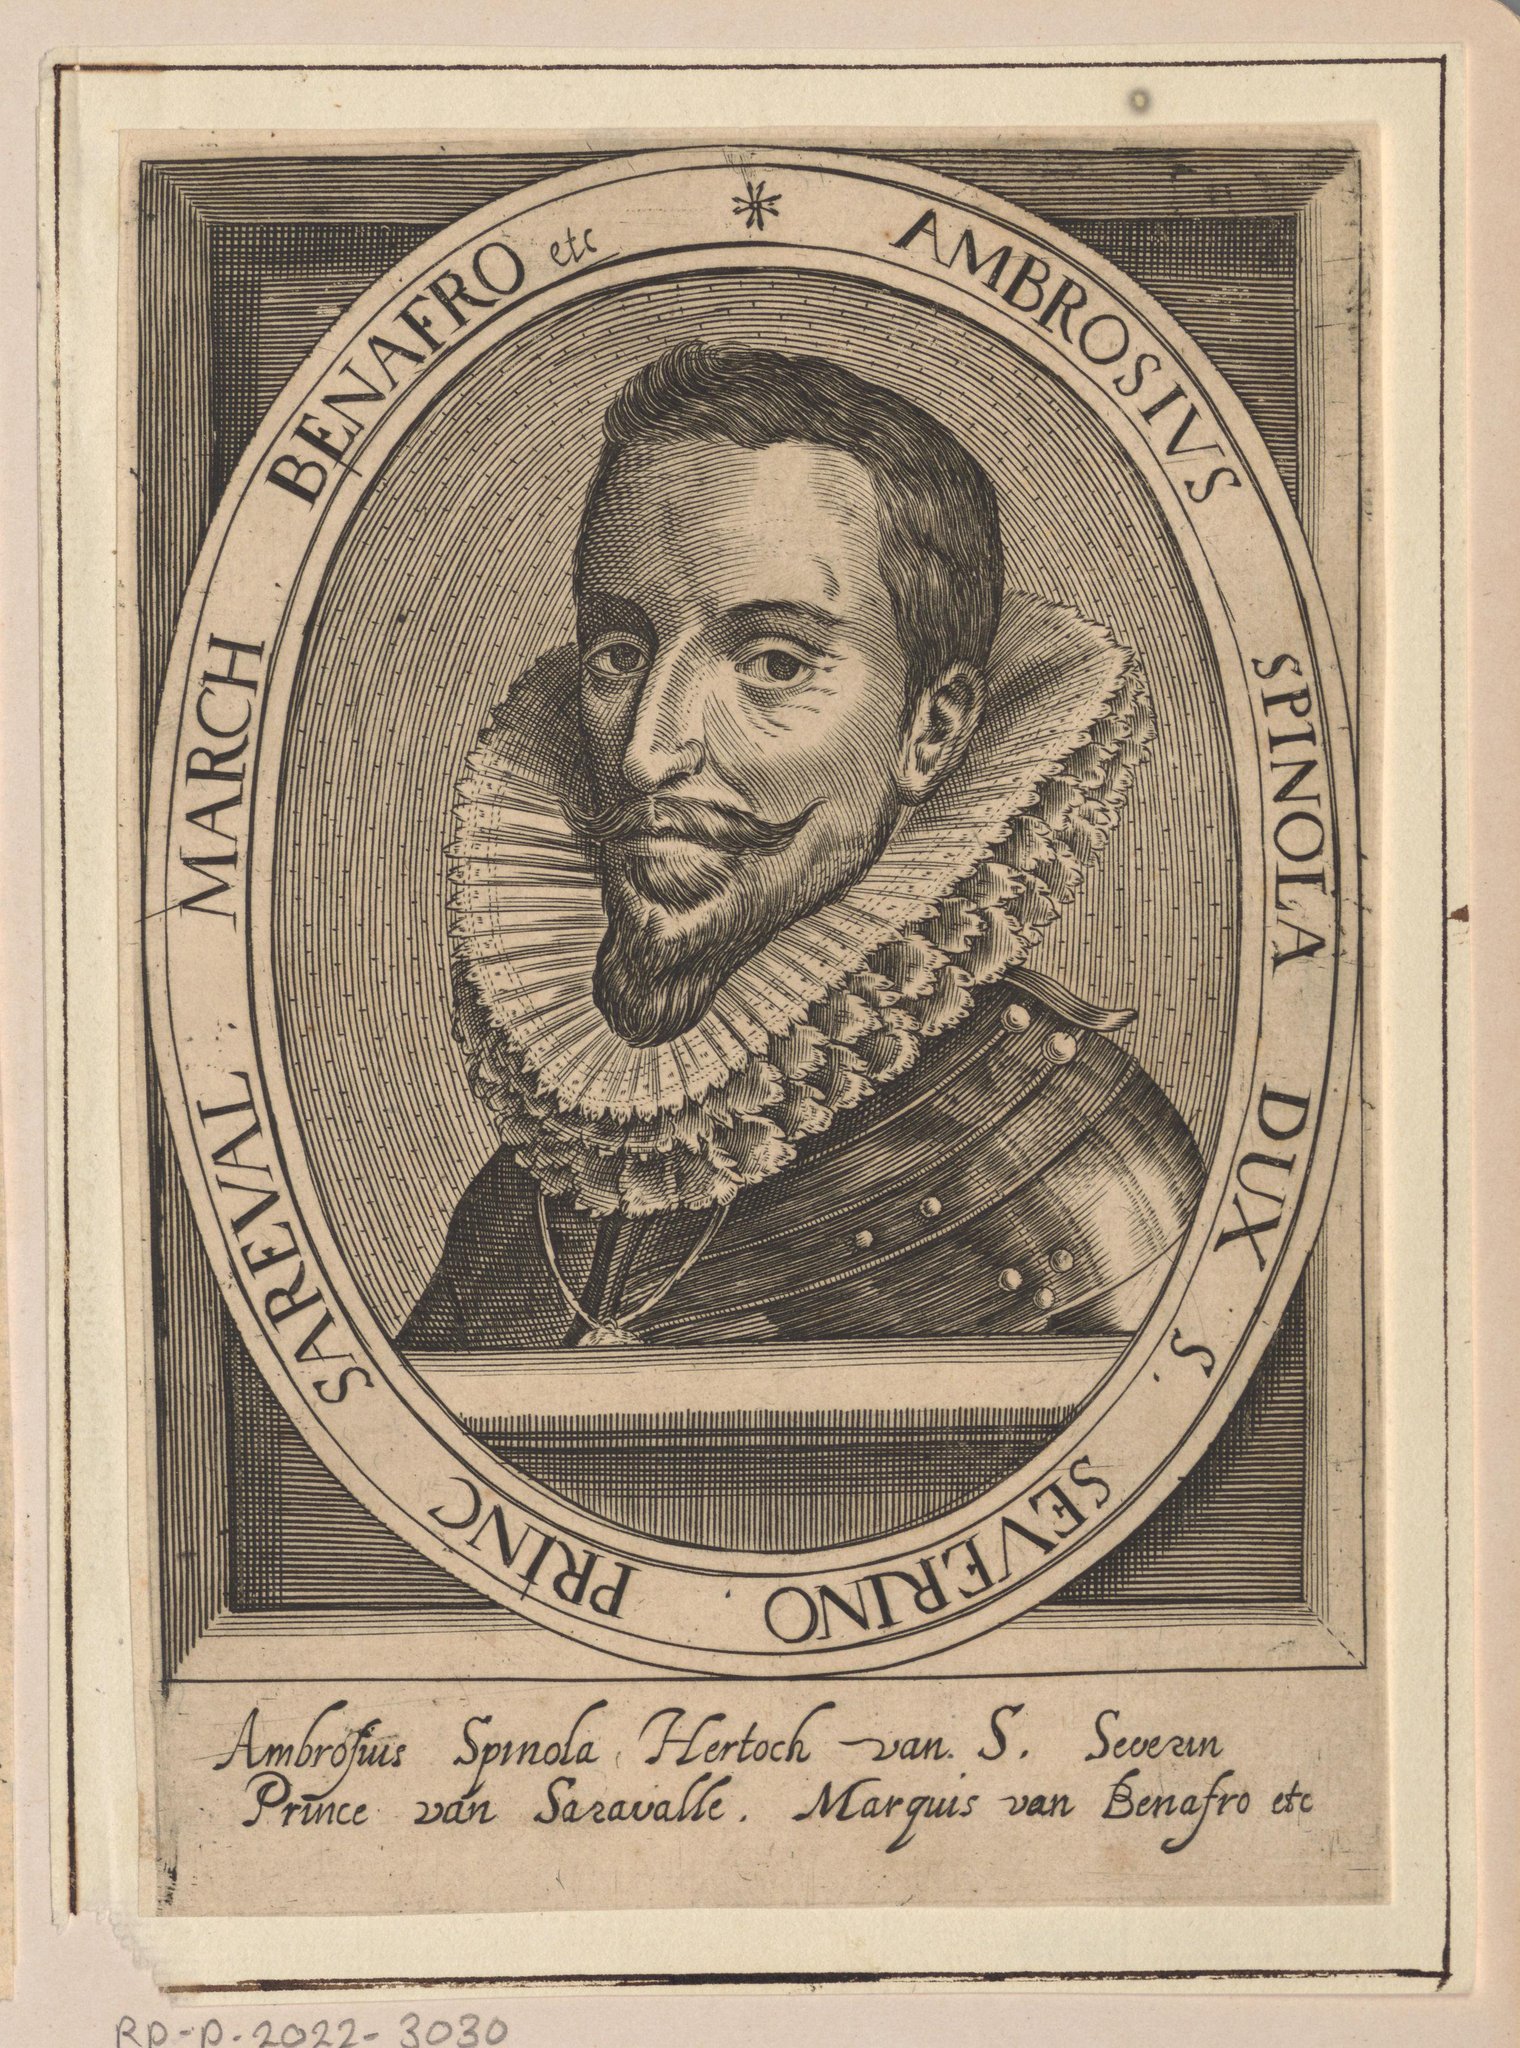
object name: print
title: Portret van Ambrosius Spinola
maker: Anonymous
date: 1600-1699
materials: ink, paper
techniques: engraving, pen, snipping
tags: commander-in-chief, general, marshal, historical persons, knighthood order of the golden fleece - insignia of a knighthood order, e.g.: badge, chain (with name of order)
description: Met tweeregelig onderschrift in het Nederlands en tekst in het Latijn rondom het portret.